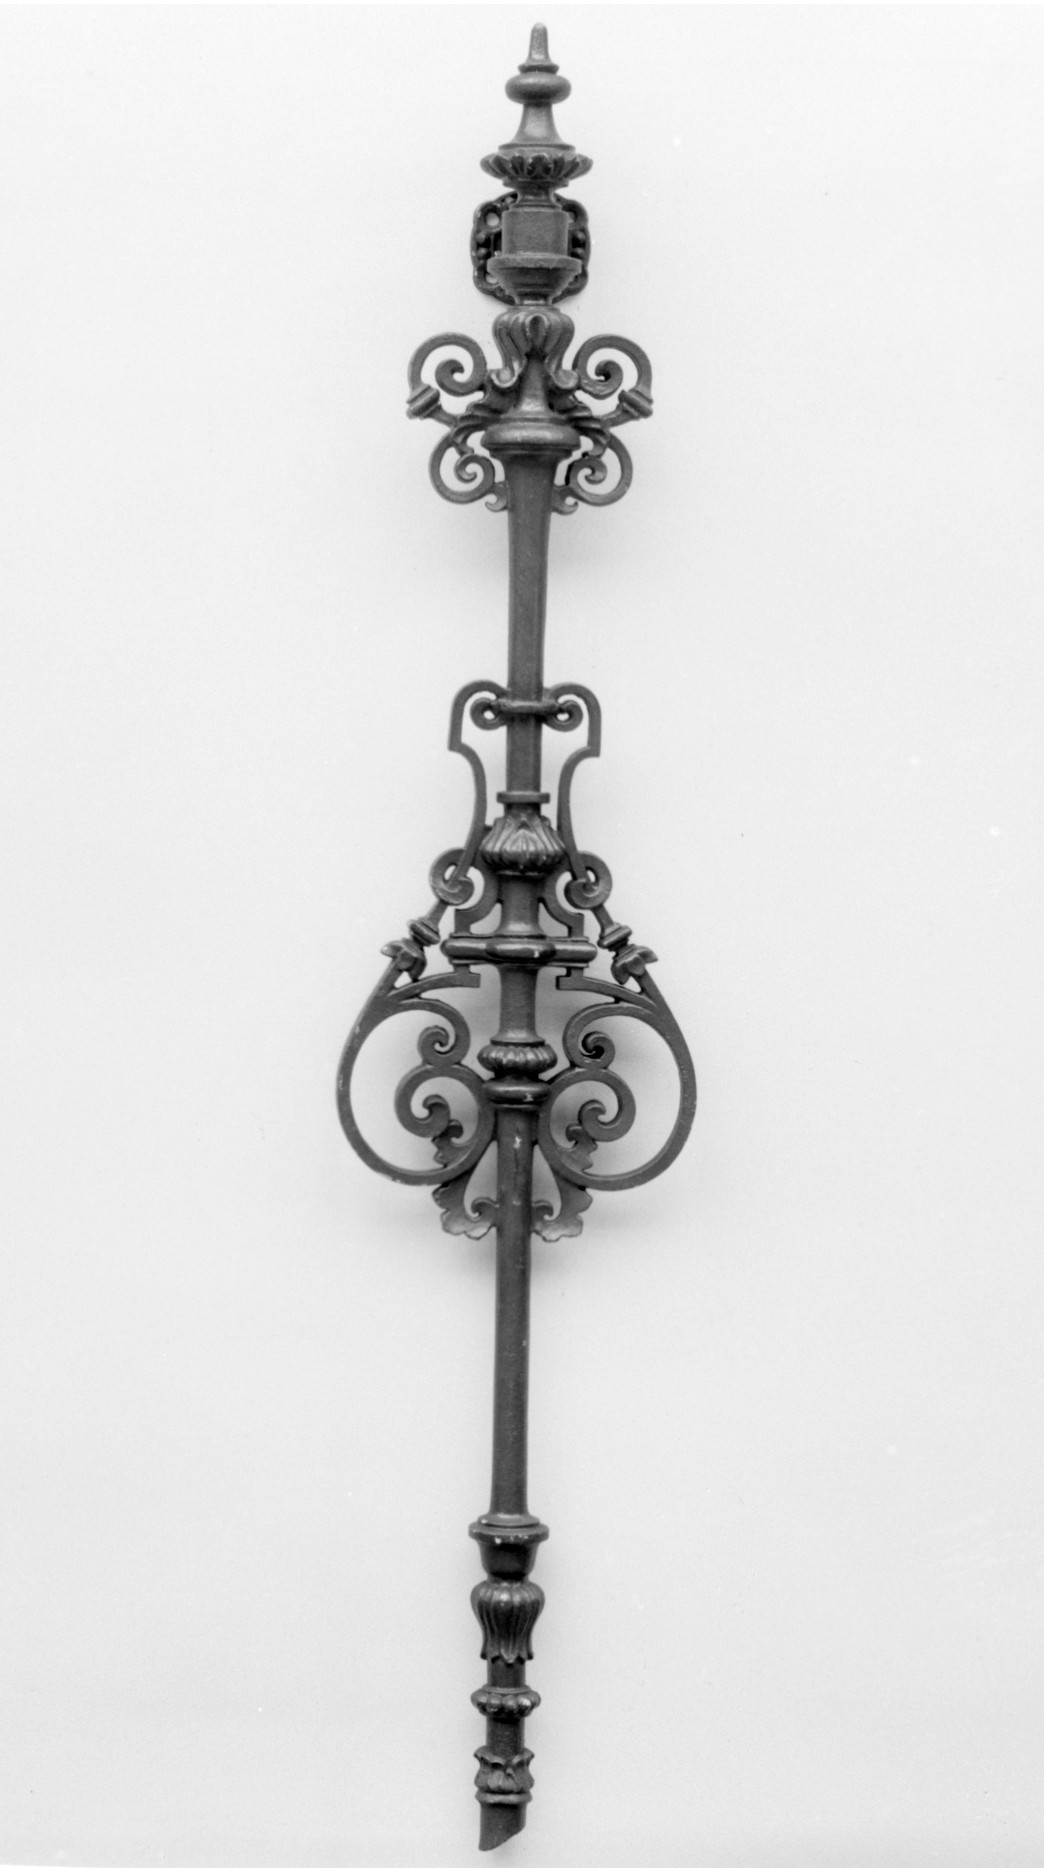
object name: baluster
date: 1767-1833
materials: iron